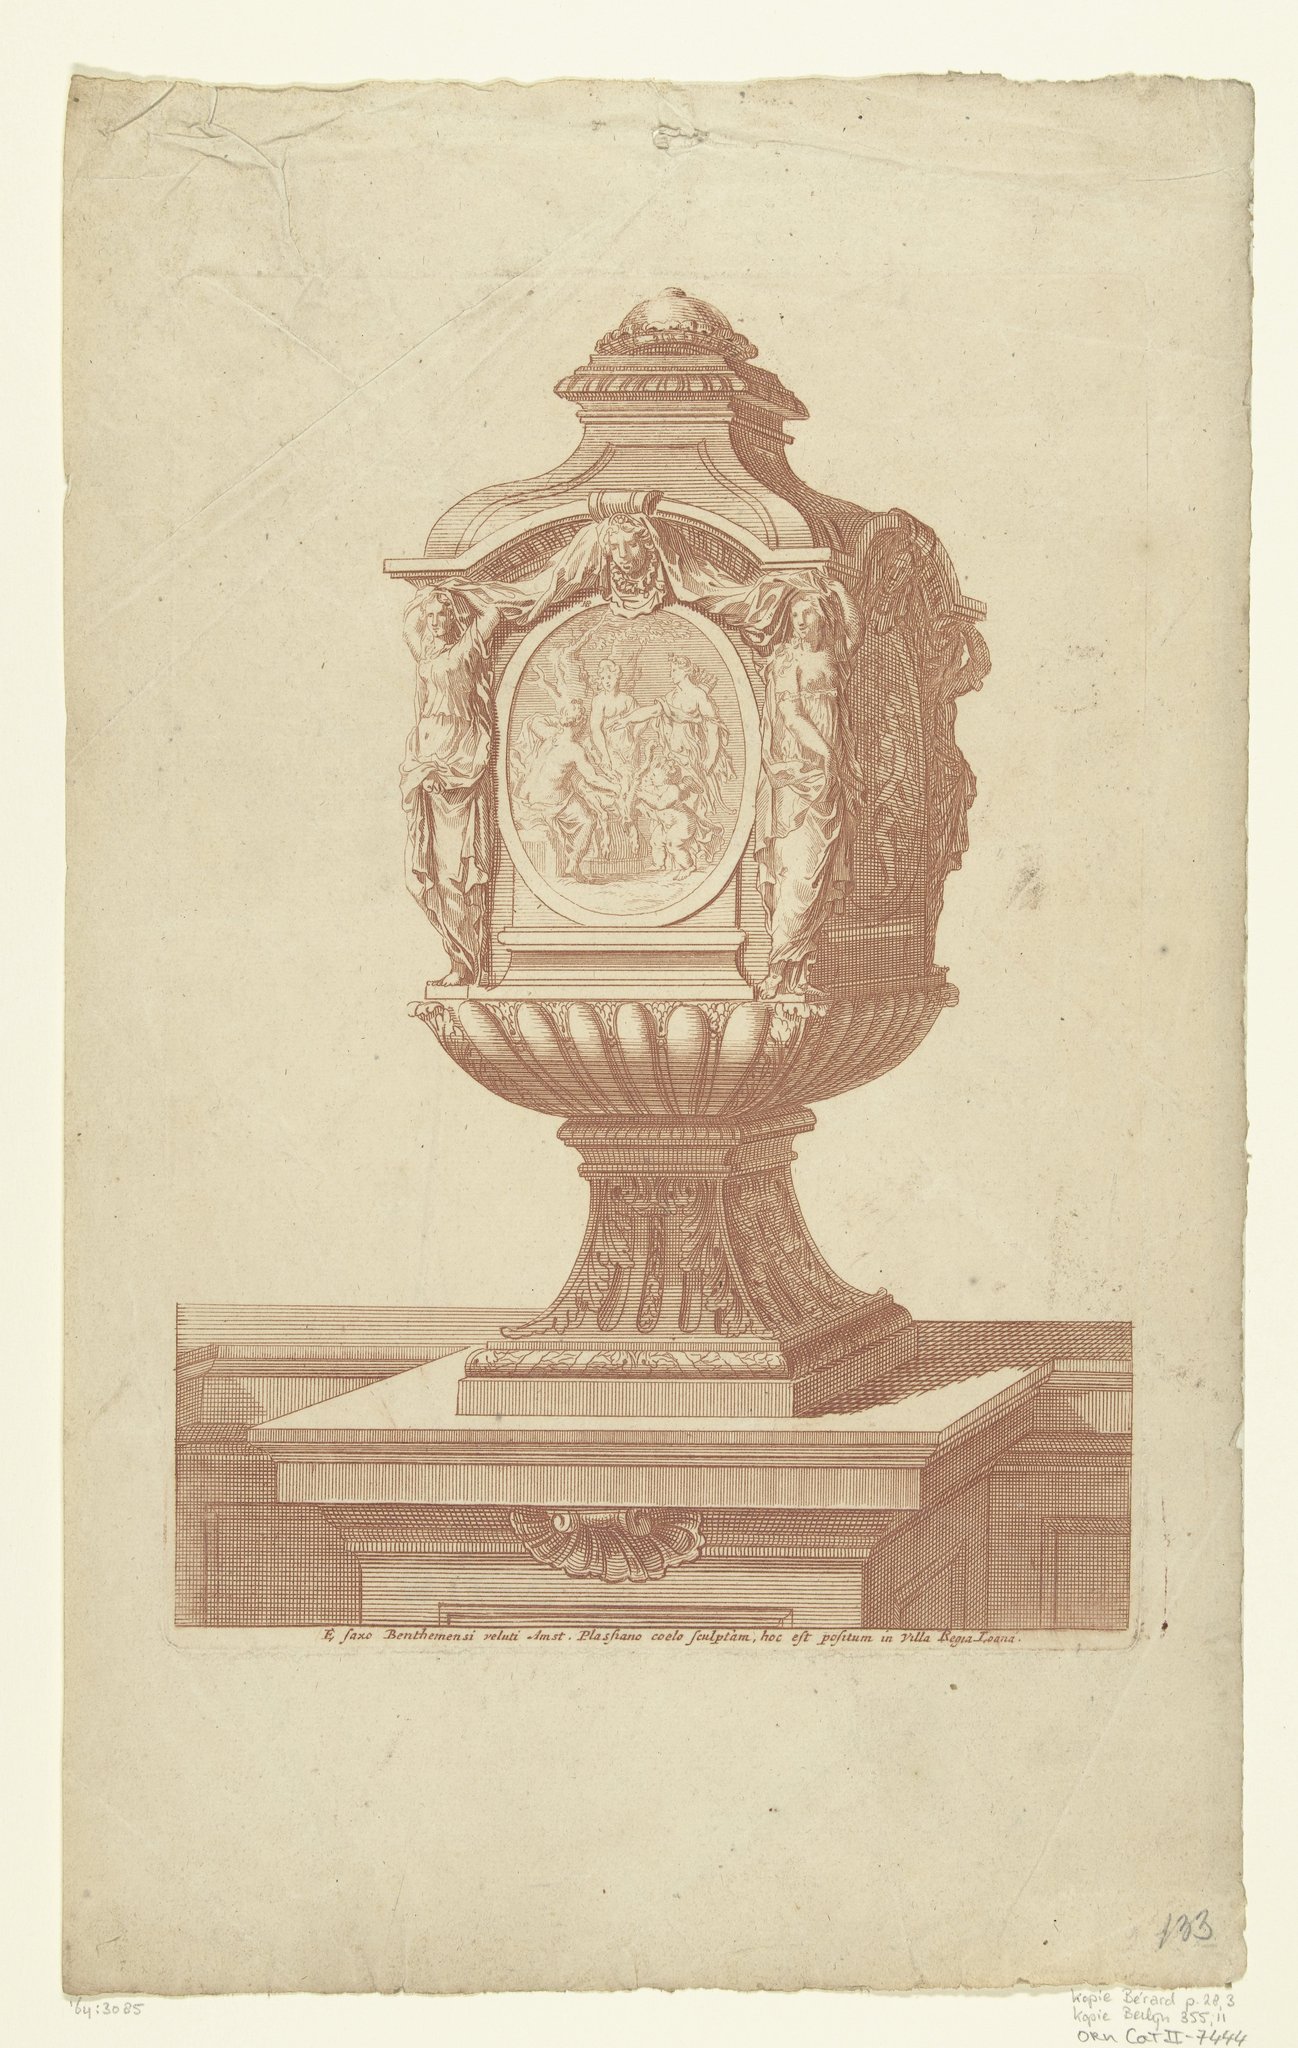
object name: ornament print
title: Tuinvazen van Paleis Het Loo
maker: Anonymous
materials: paper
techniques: etching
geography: netherlands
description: Vaas op een vierkante voet met bas-reliëf met vier kariatiden op de hoeken van de vaas. Daartussen ovale bas-reliëfs, de voorste met Diana en Cupido. In de ondermarge een Latijnse tekst.Kopie naar blad uit de serie Vasses de la Maison Royalle de L'oo. Uit serie van 6 bladen.